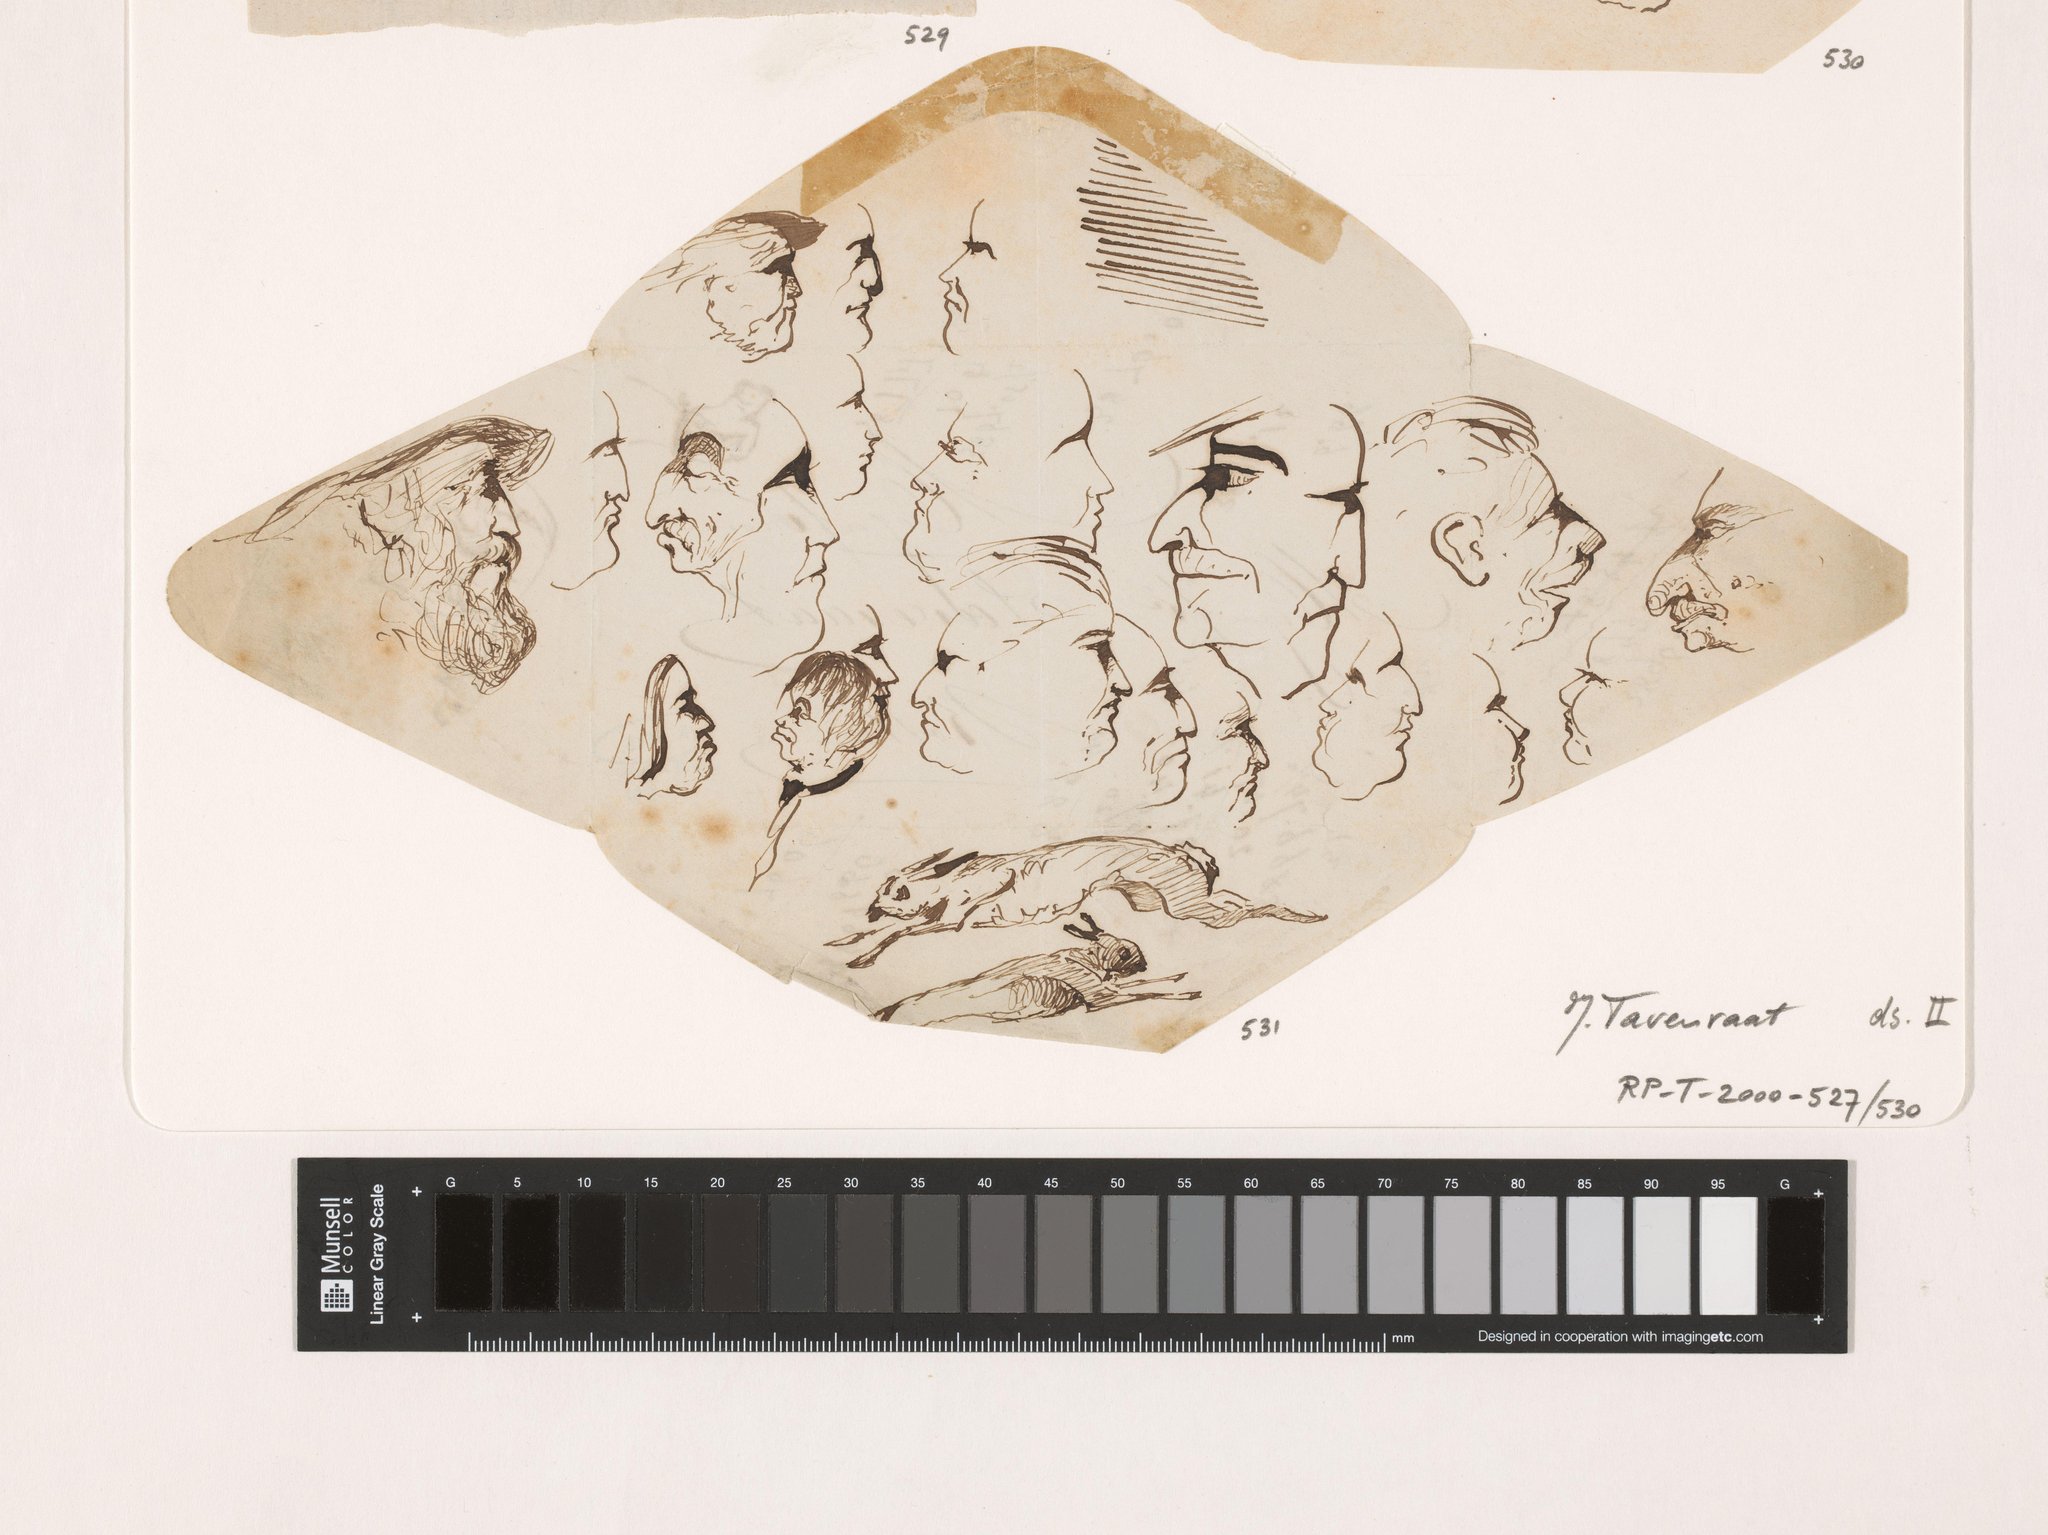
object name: drawing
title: Koppen en hazen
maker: johannes tavenraat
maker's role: draughtsman, painter, print maker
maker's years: 1809-1881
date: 1840-1880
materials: ink, paper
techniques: pen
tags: head (human), caricatures (human types), rodents: hare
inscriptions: collector's mark: Lugt 2228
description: Haas en koppen. Getekend op de achterzijde van een opengevouwen envelop gericht aan mejuff. Tavenraat.